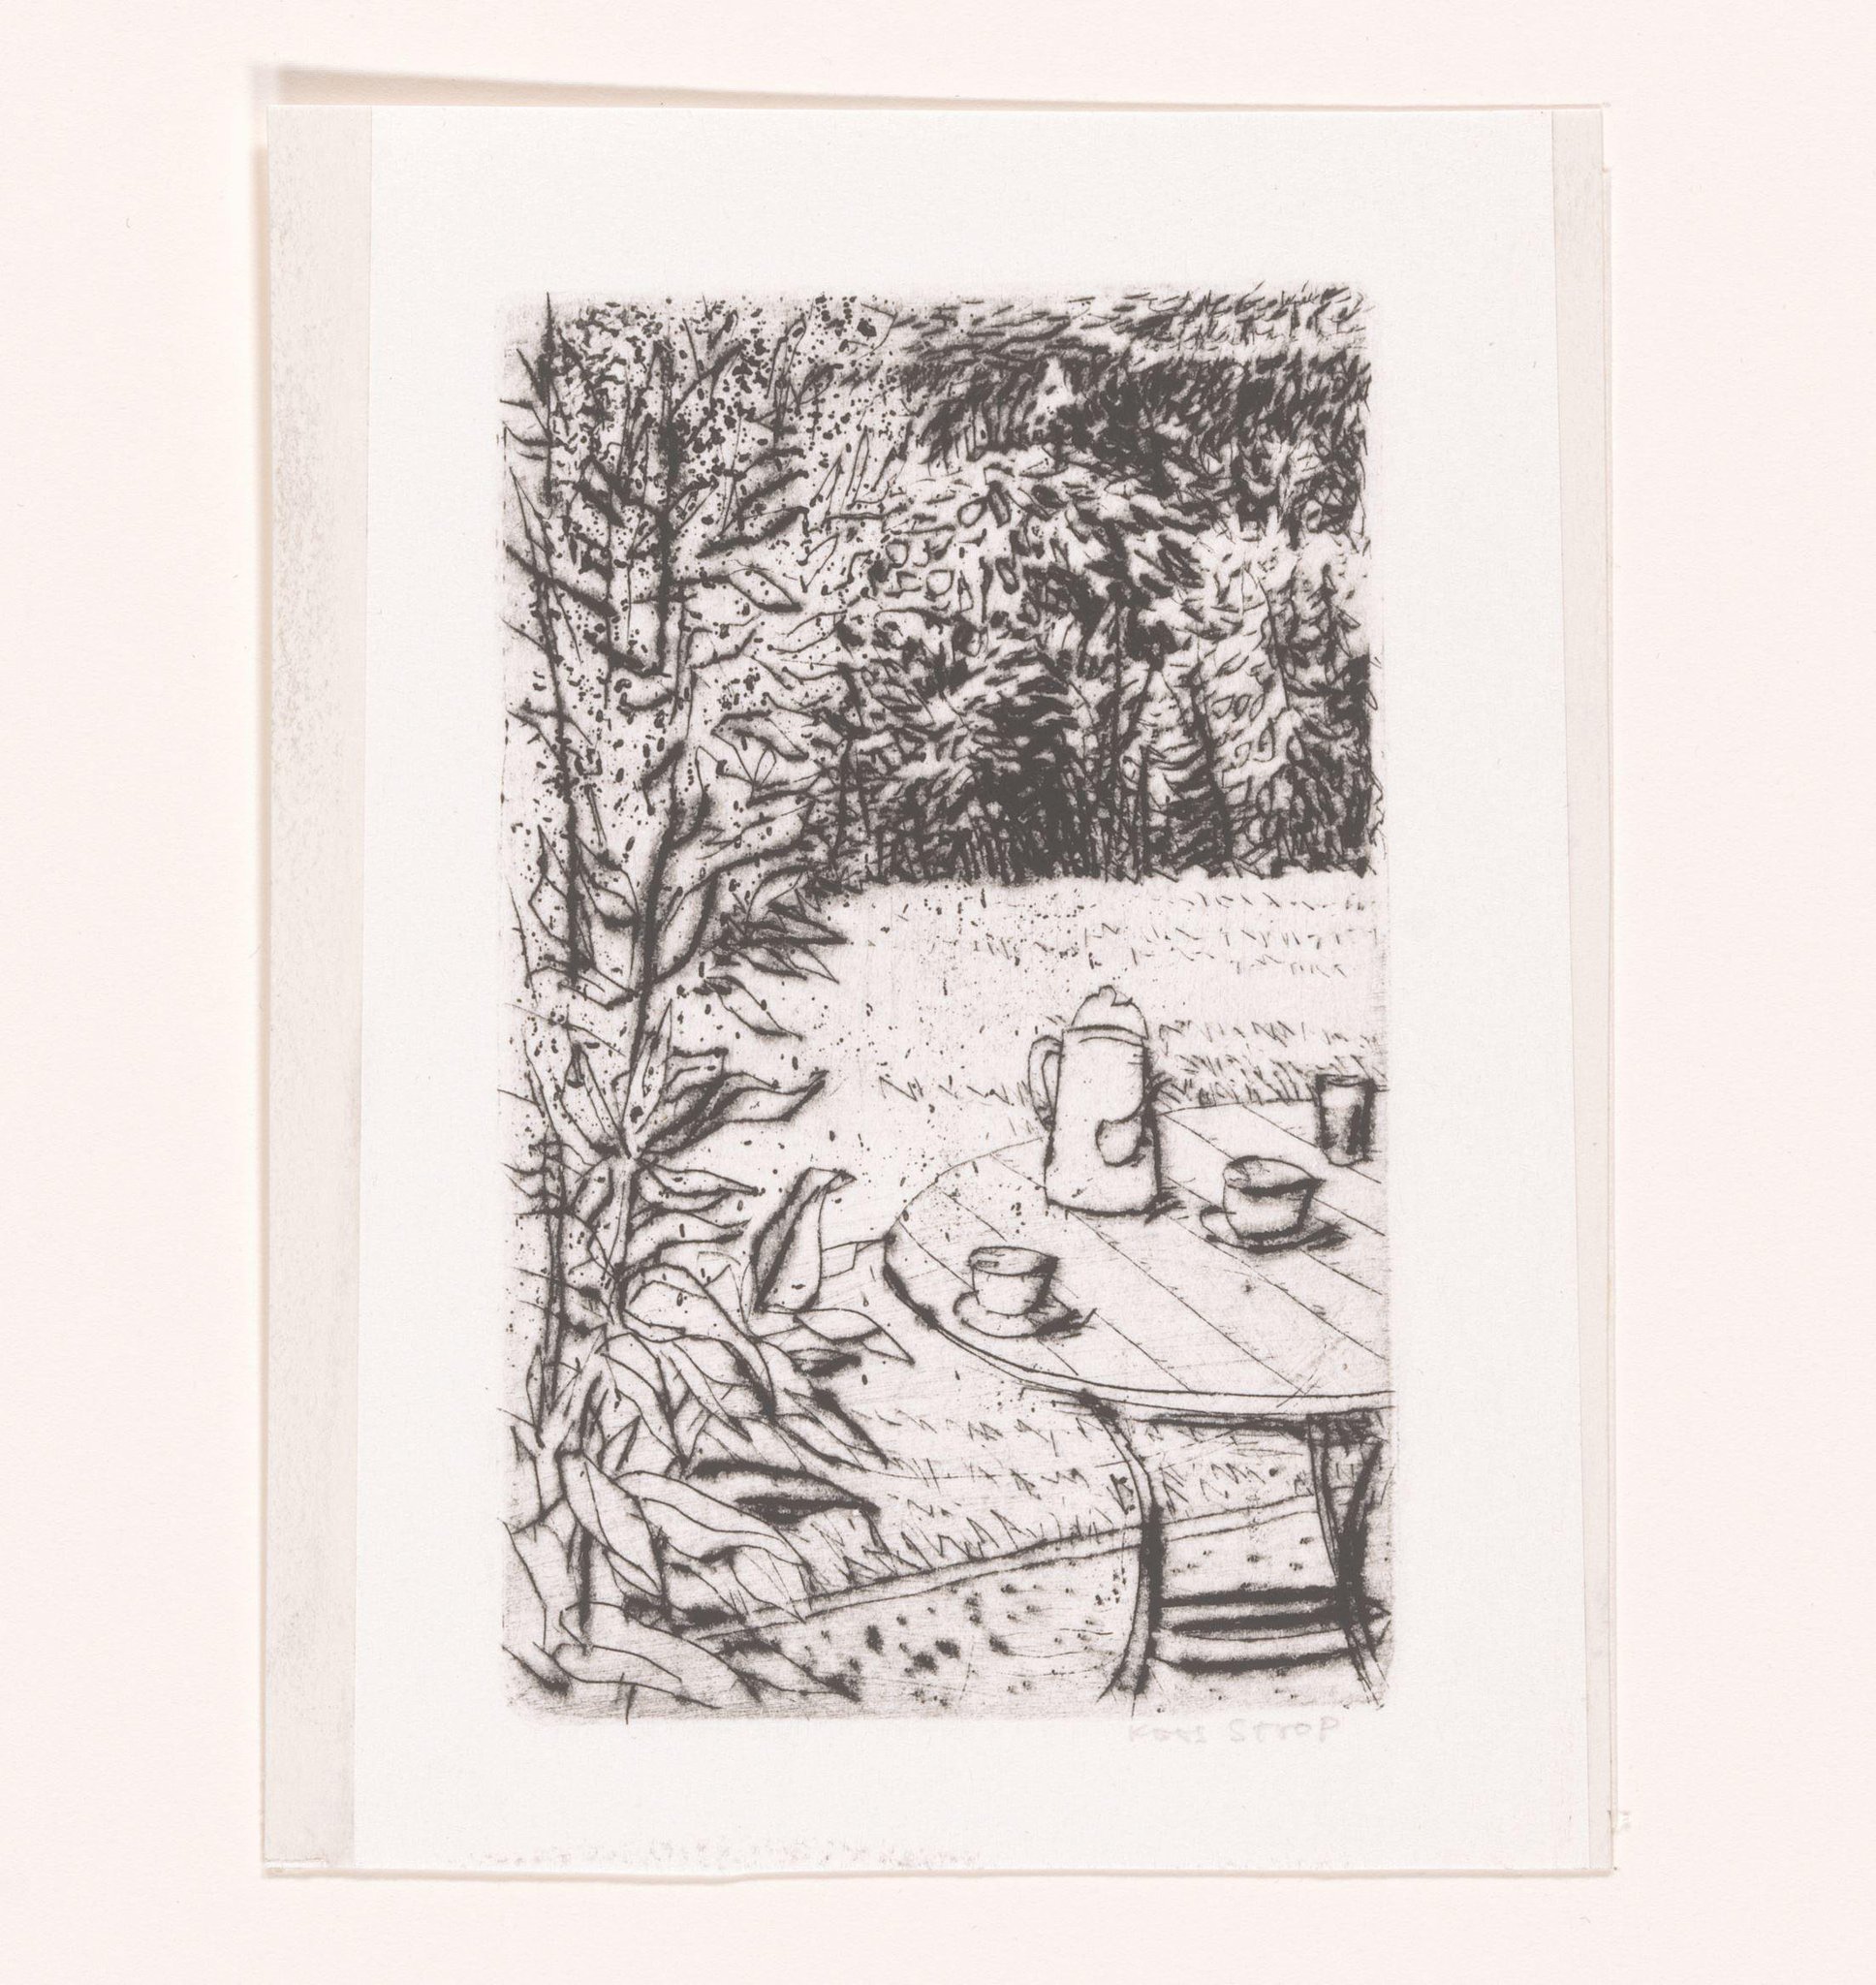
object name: print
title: Tuintafelt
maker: kees stoop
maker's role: draughtsman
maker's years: 1929-2019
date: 1944-1990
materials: paper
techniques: drypoint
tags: garden, tea- and coffee-service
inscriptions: signature: ‘KEES STOOP’